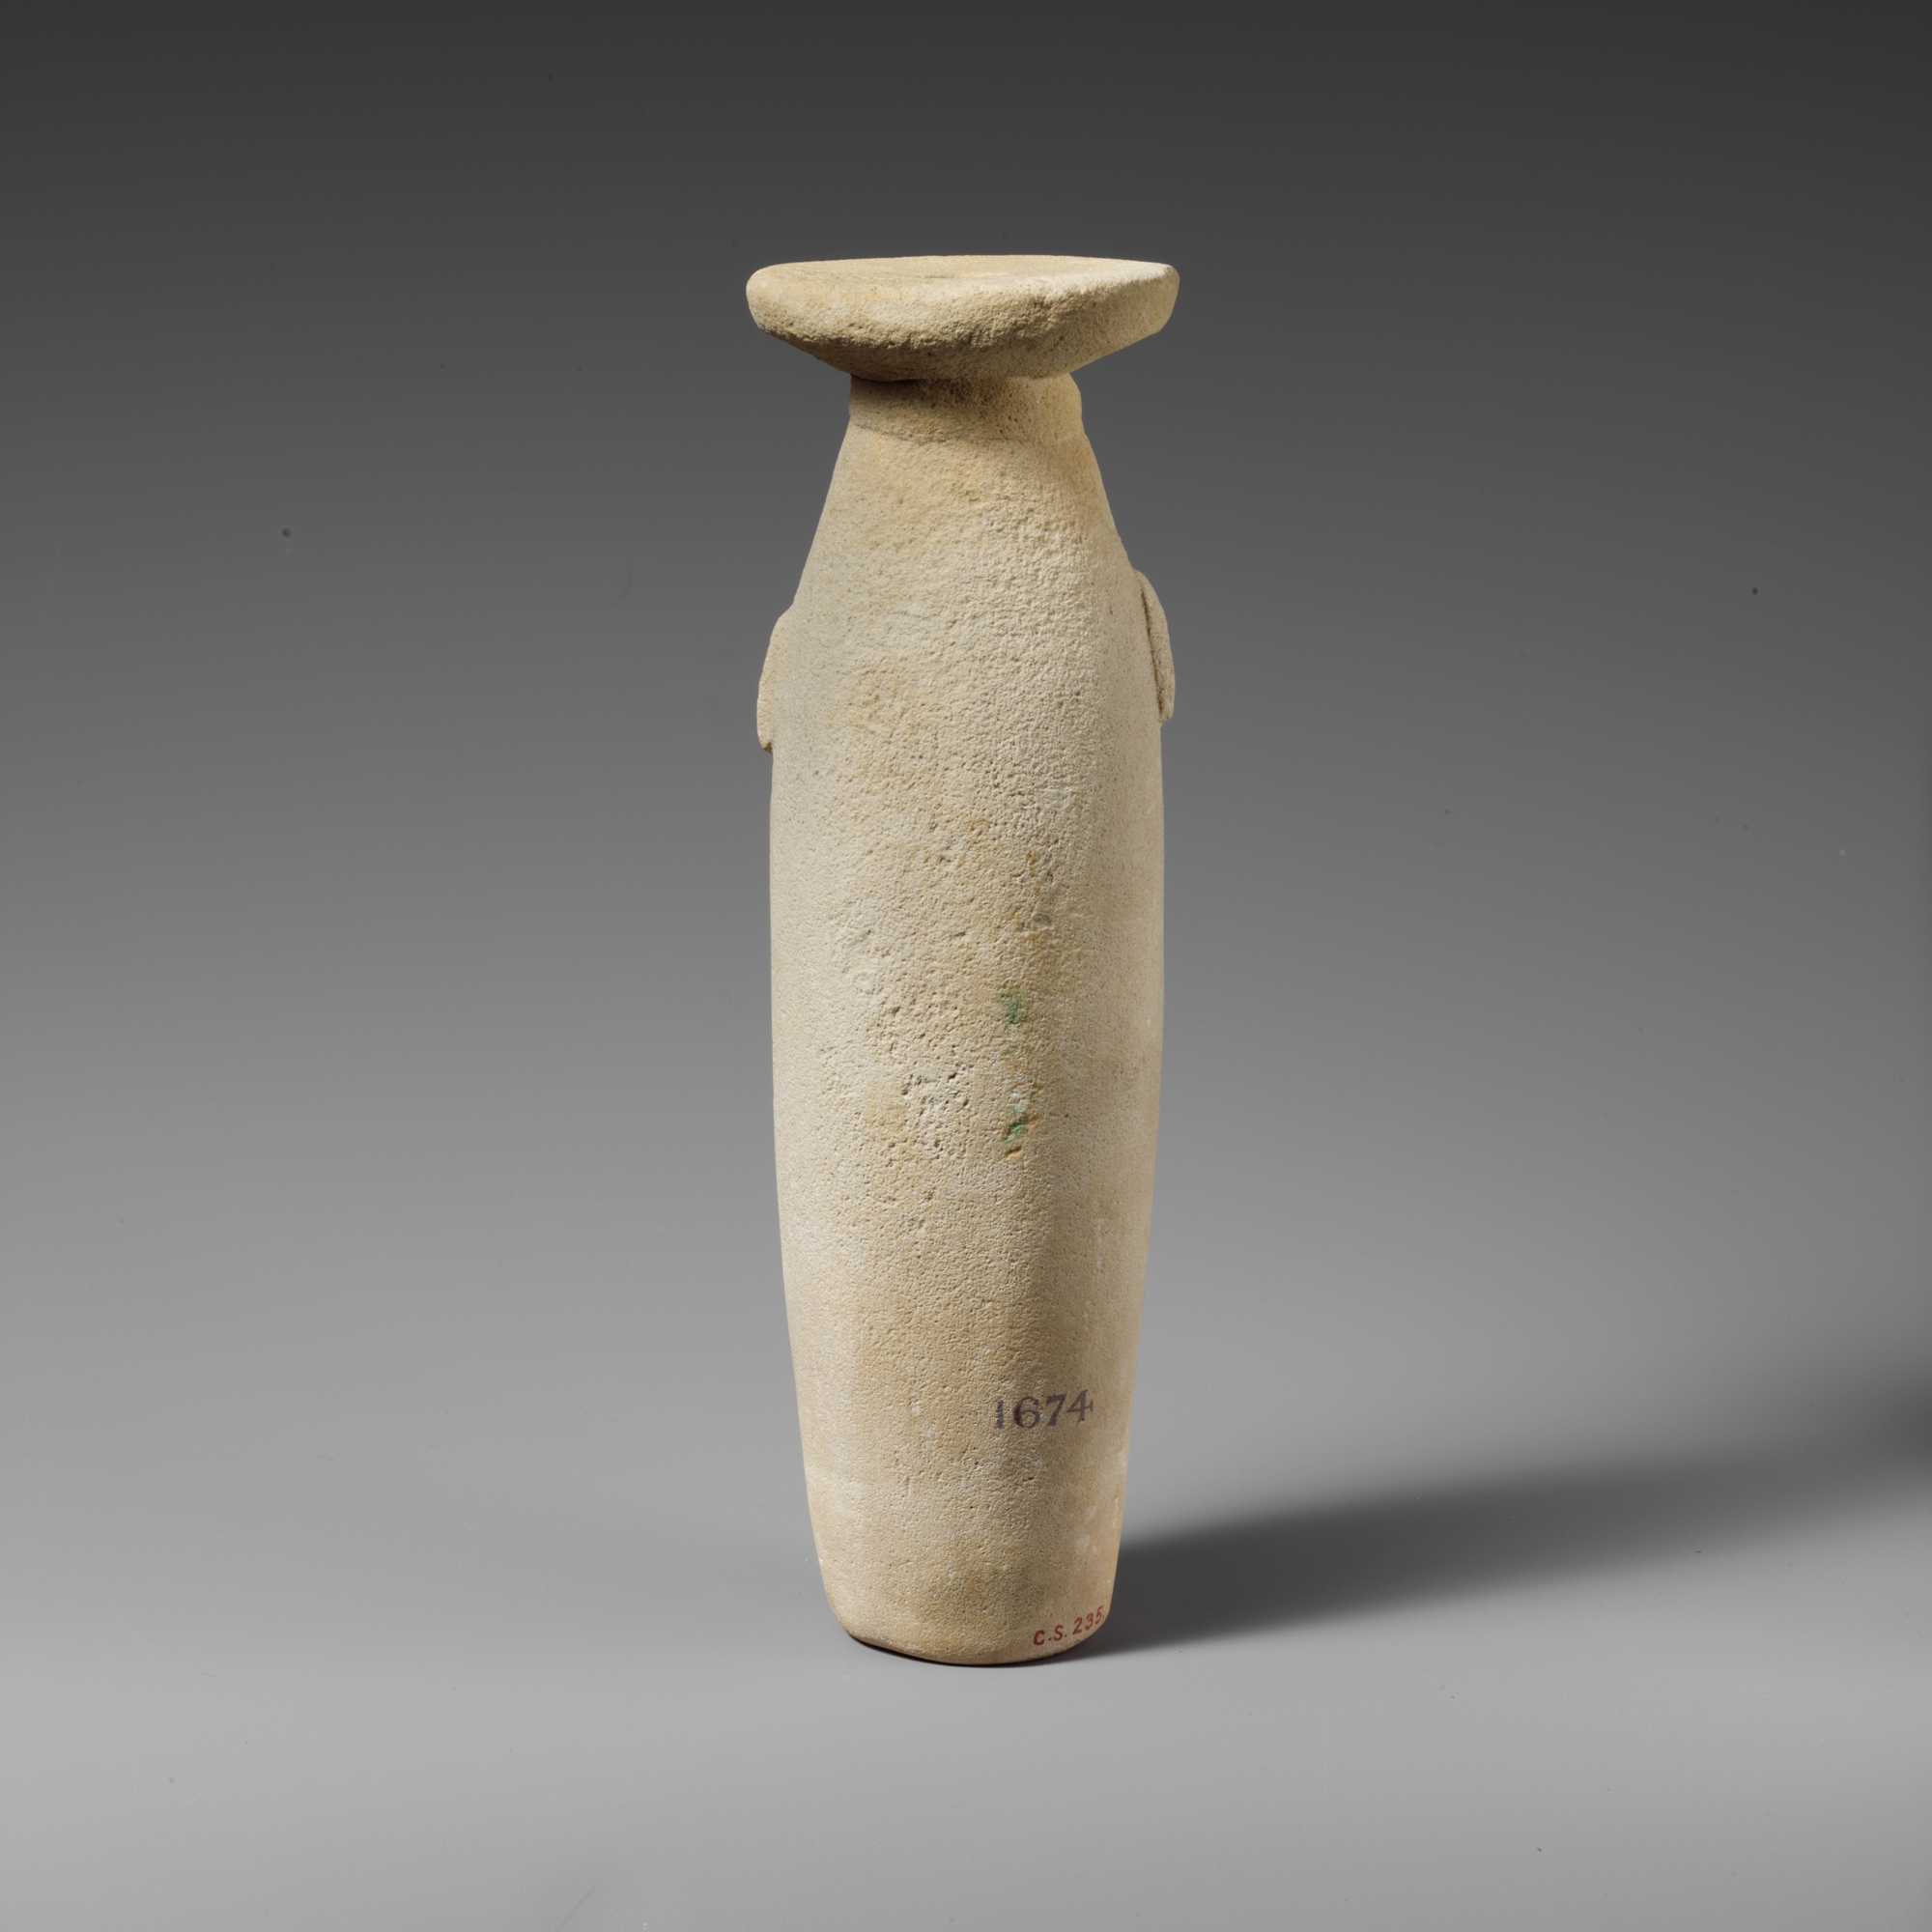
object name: alabastron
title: Limestone alabastron (perfume vase)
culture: cypriot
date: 600-401 BCE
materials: limestone